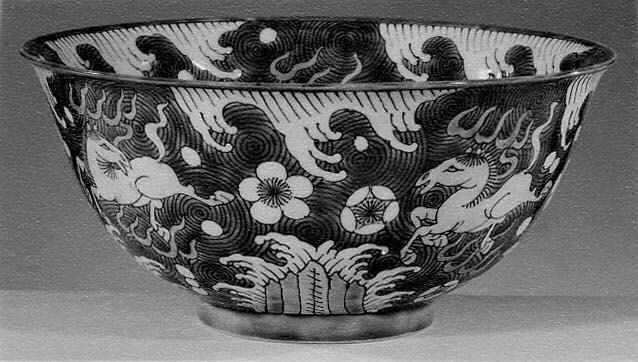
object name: bowl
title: Bowl (one of a pair)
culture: chinese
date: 1601-1800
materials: enamel, porcelain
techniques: overglaze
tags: horses,flowers